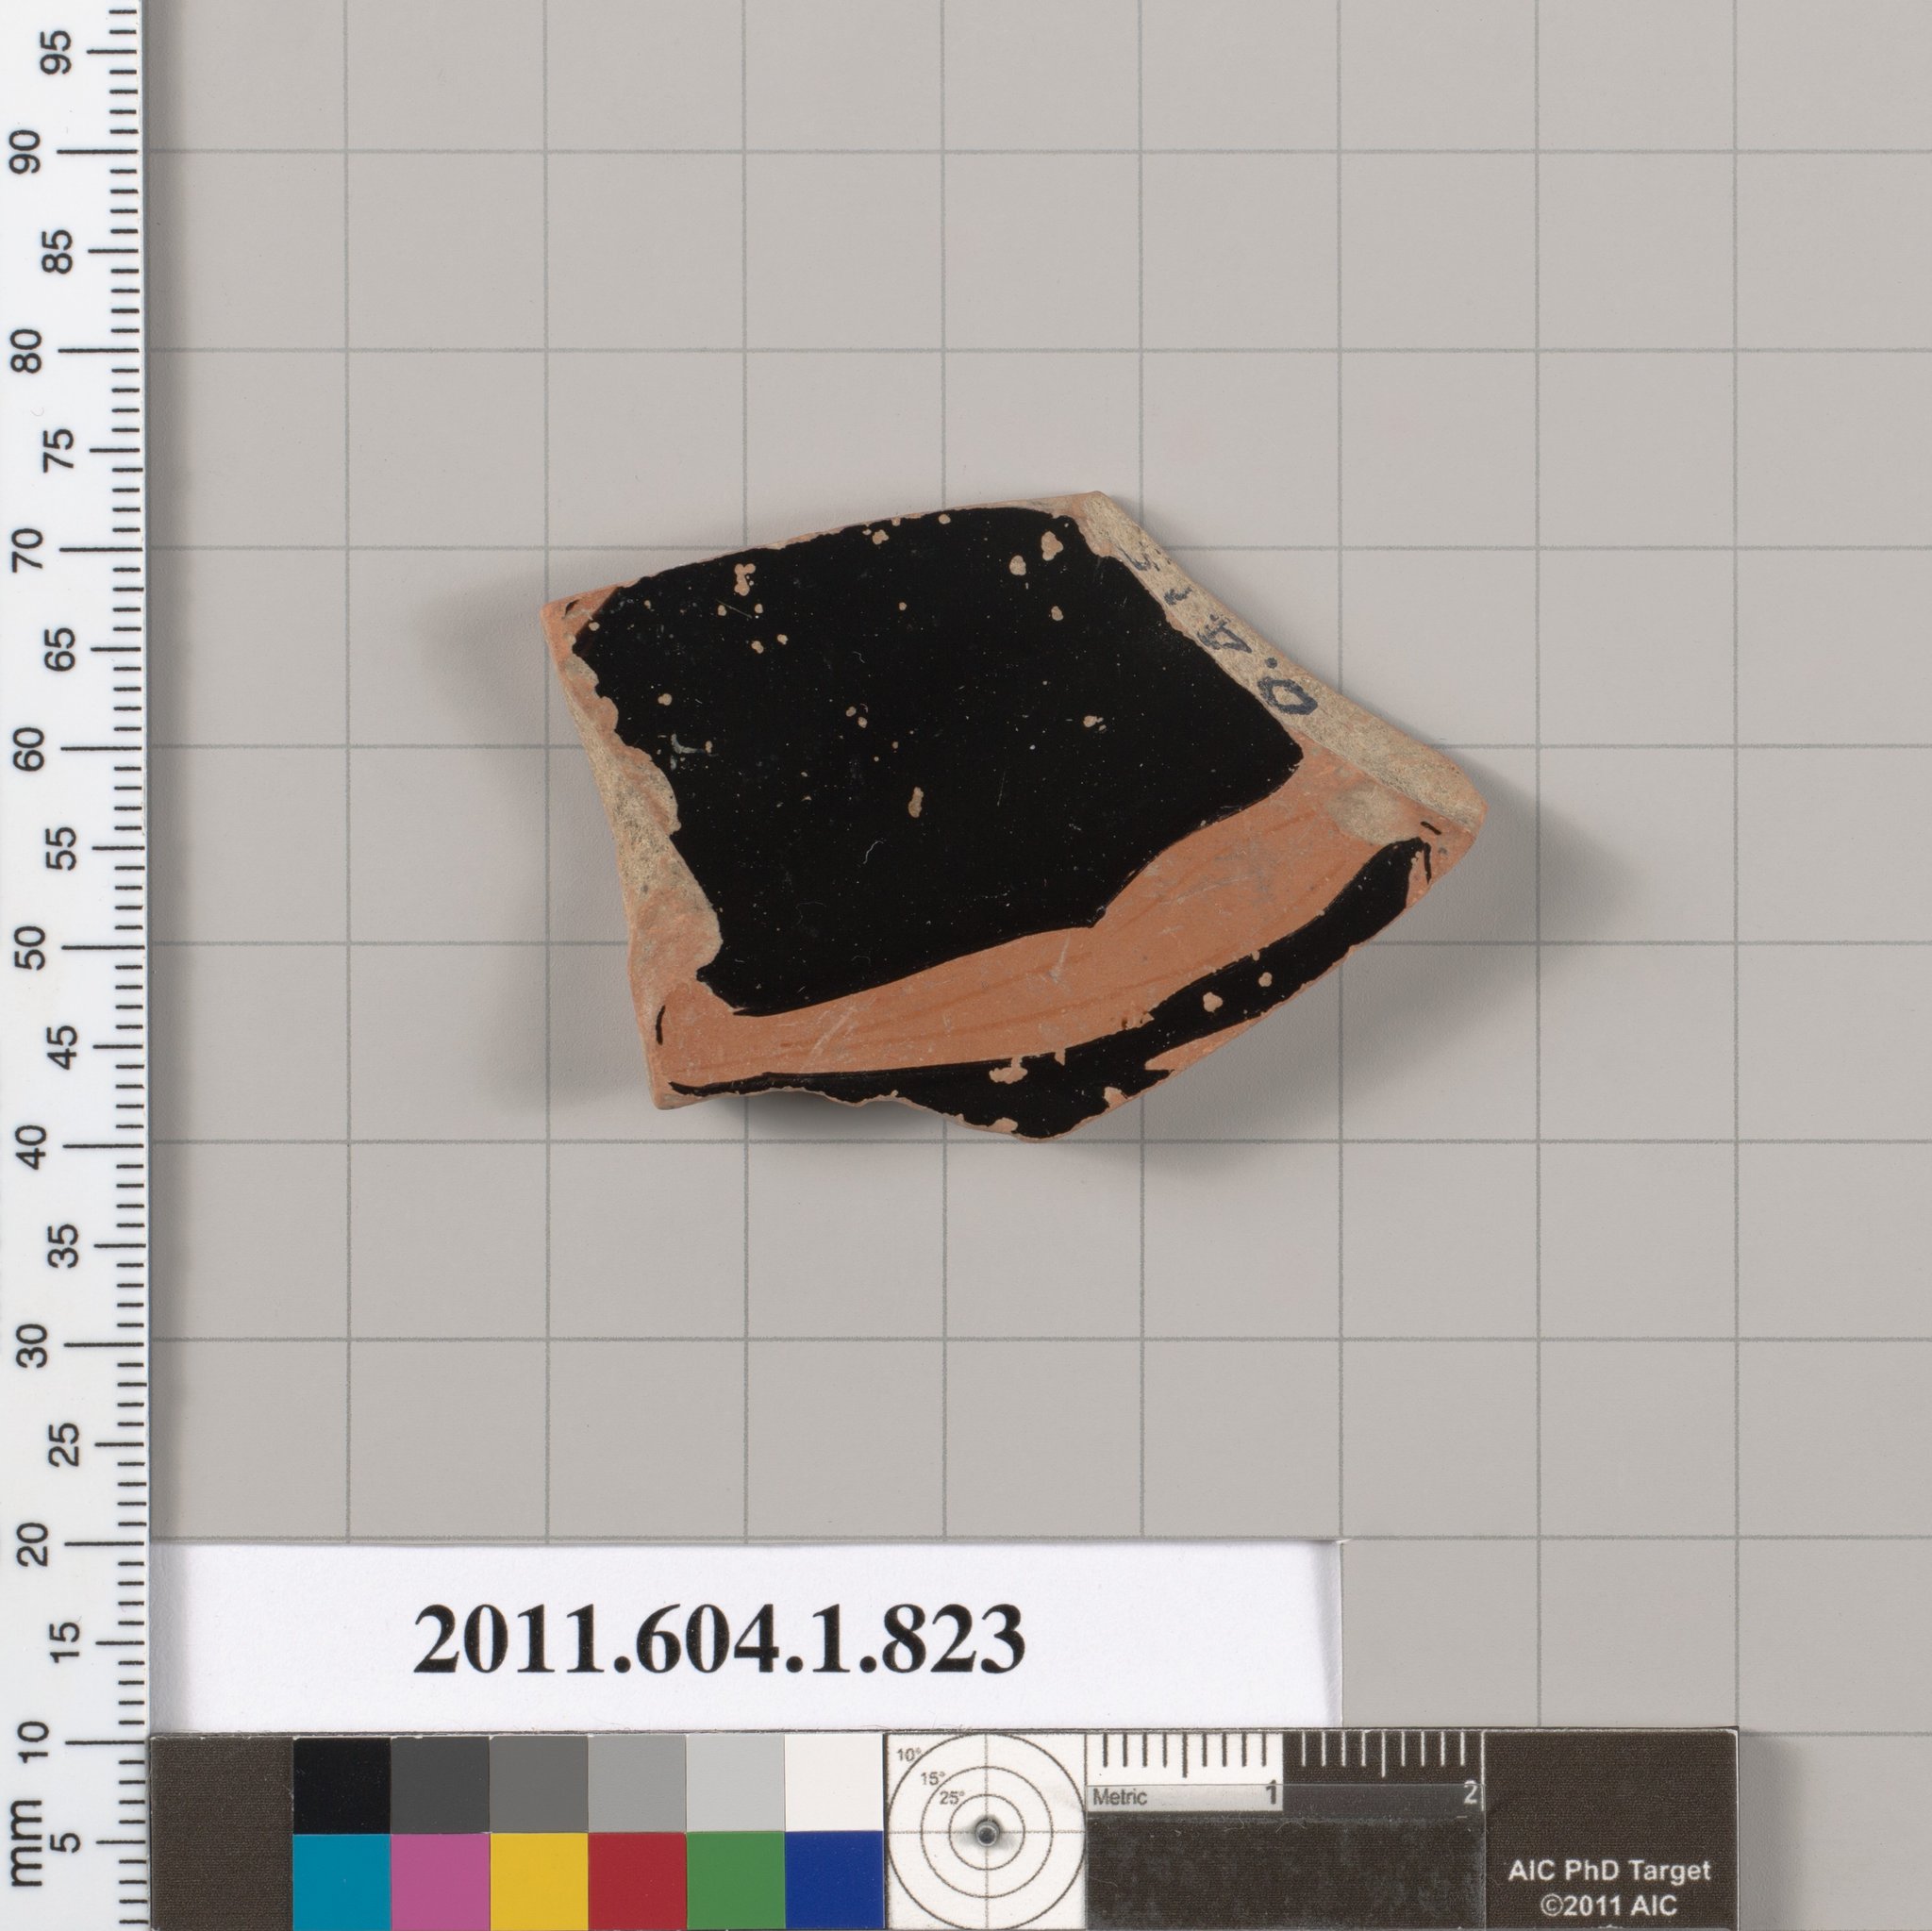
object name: kylix fragment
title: Terracotta fragment of a kylix (drinking cup)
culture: greek, attic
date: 475-451 BCE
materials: terracotta